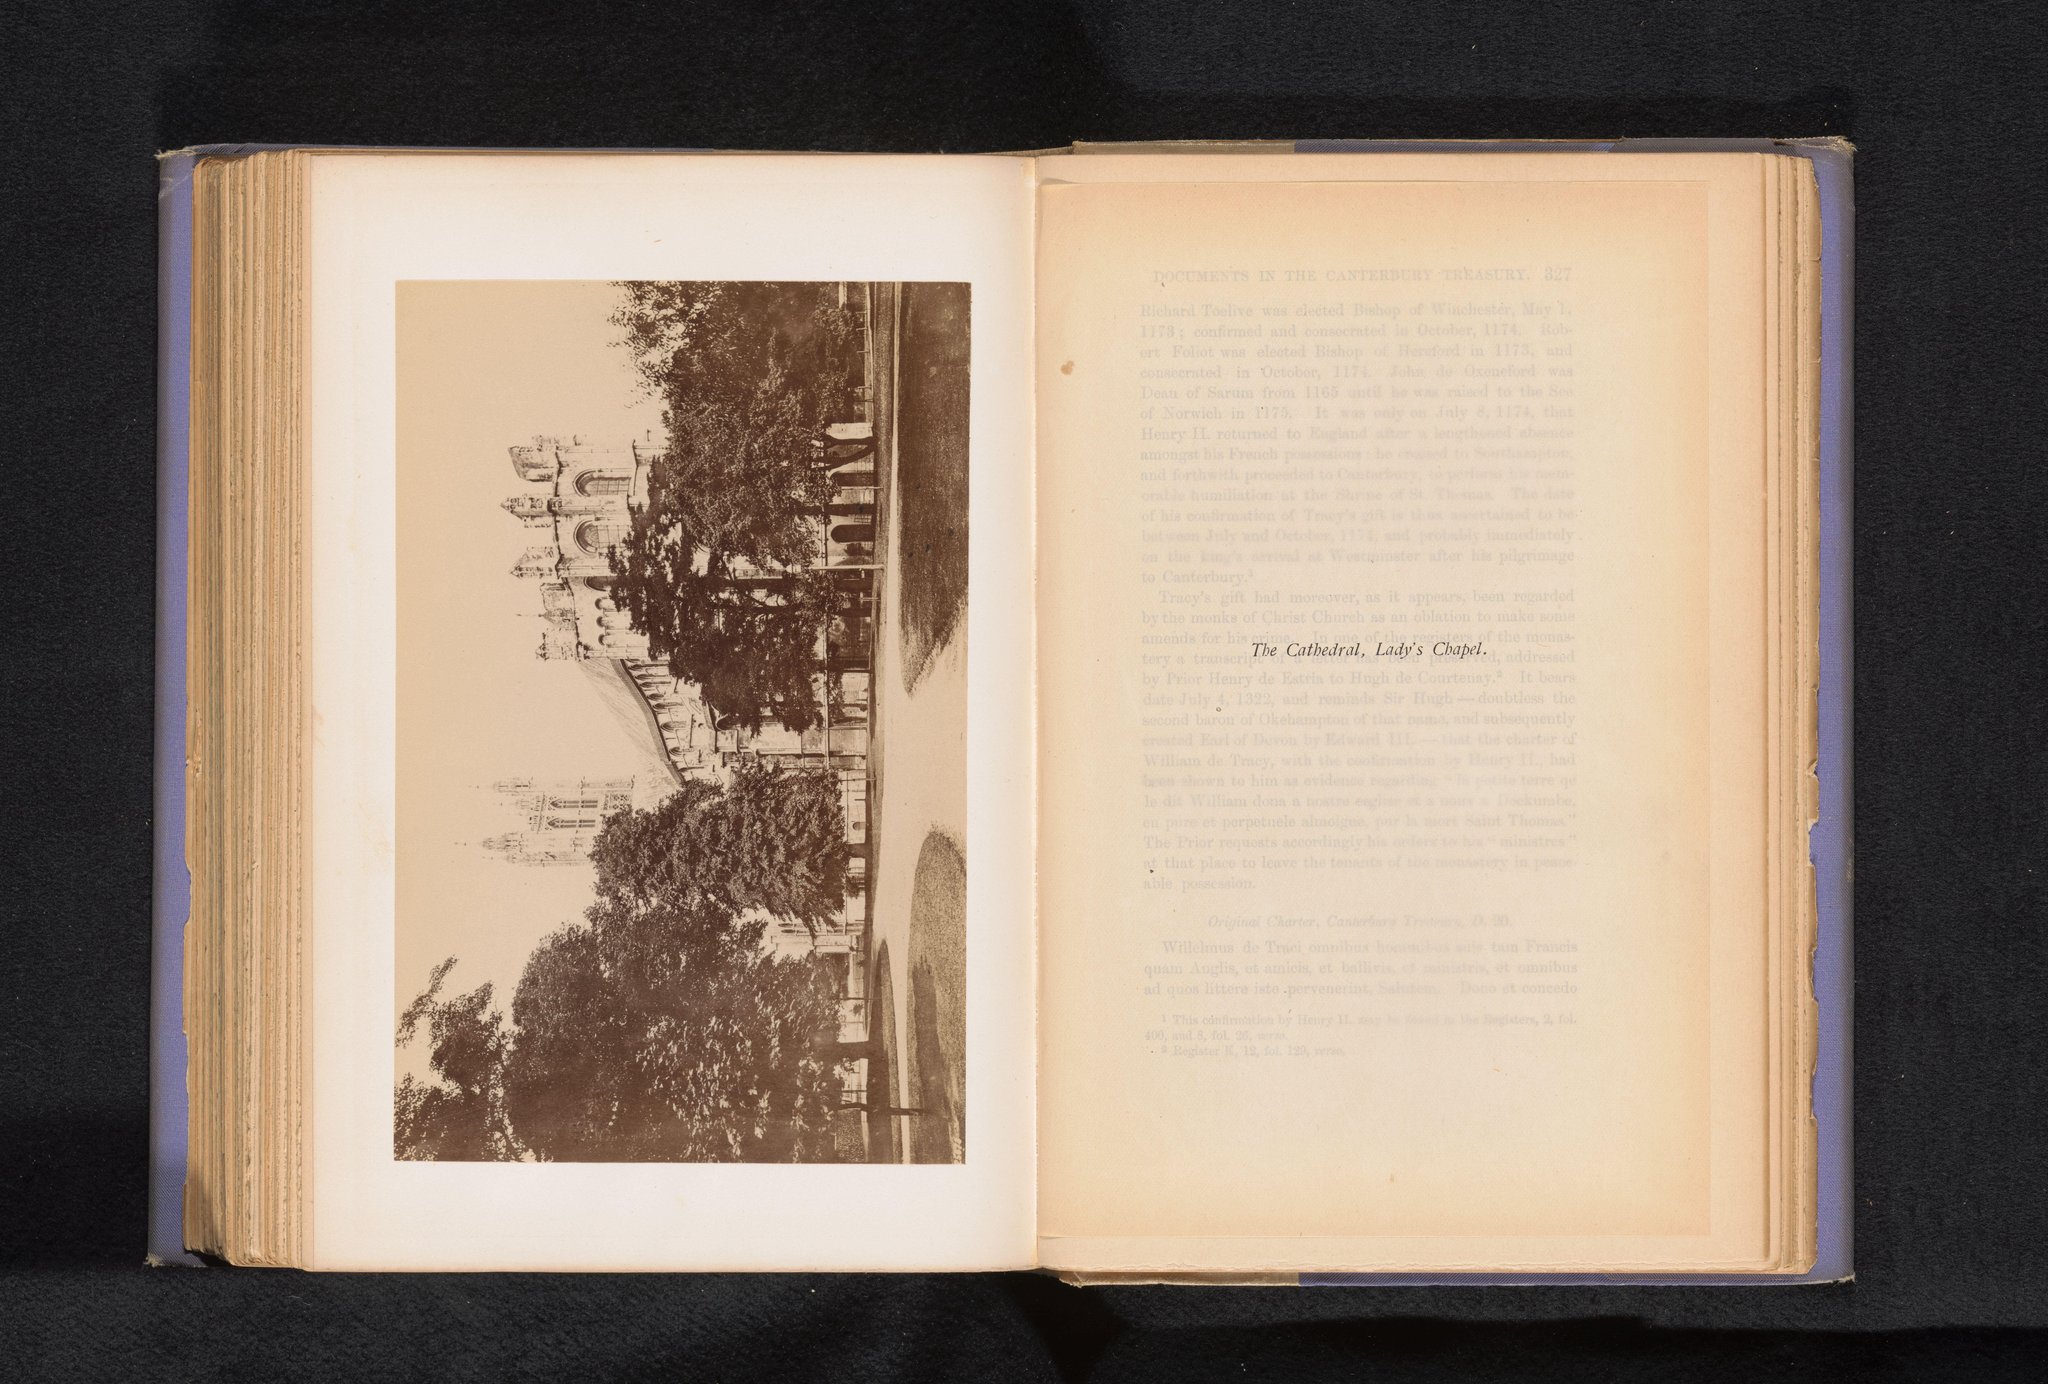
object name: page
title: Gezicht op de kathedraal van Canterbury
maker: Anonymous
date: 1882-1892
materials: photographic support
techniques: albumen print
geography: canterbury cathedral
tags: parts of church exterior and annexes: chapel, church (exterior)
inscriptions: number: ‘25673’